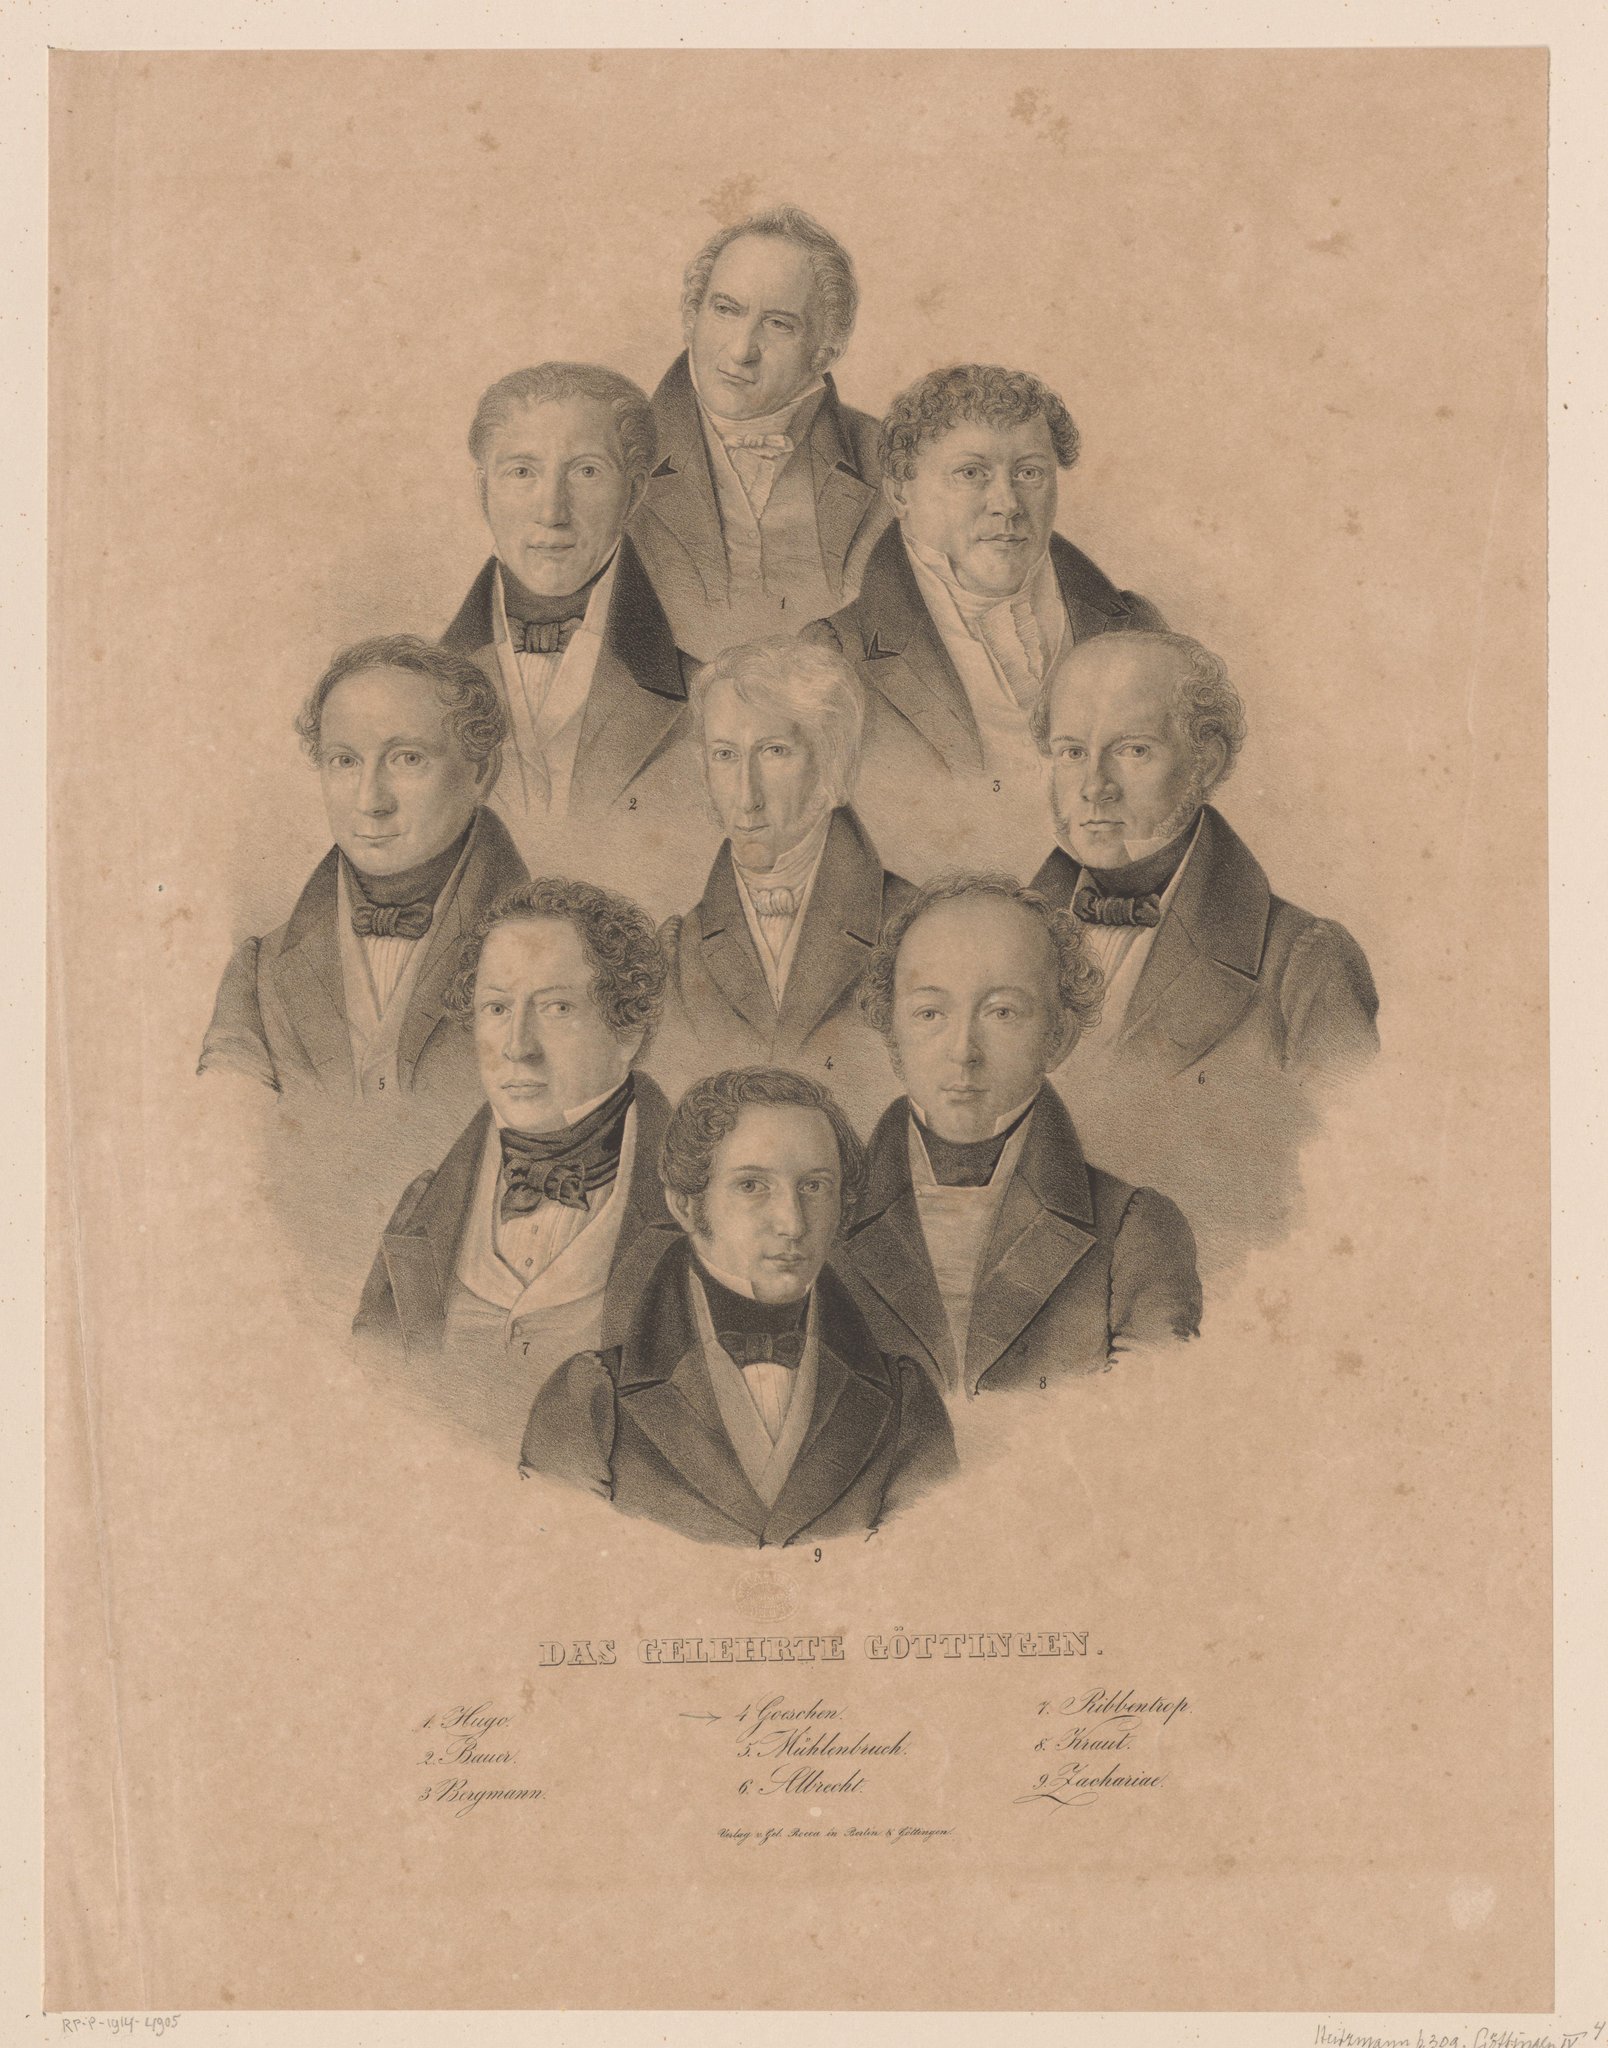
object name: print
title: Portretten van negen geleerden uit Göttingen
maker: Anonymous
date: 1830-1863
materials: paper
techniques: lithograph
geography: berlin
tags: historical persons, professor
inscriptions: collector's mark: Lugt 2228, check stamp: ‘Rocca Gebruder in Gottingen’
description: Portretten van Gustav Hugo, Anton Bauer, Johann Friedrich Ludwig Göschen, Christian Friedrich Mühlenbruch, Wilhelm Eduard Albrecht, Karl Salomo Zachariae von Lingenthal, Georg Ribbentrop en Albert Jacob Kraut.